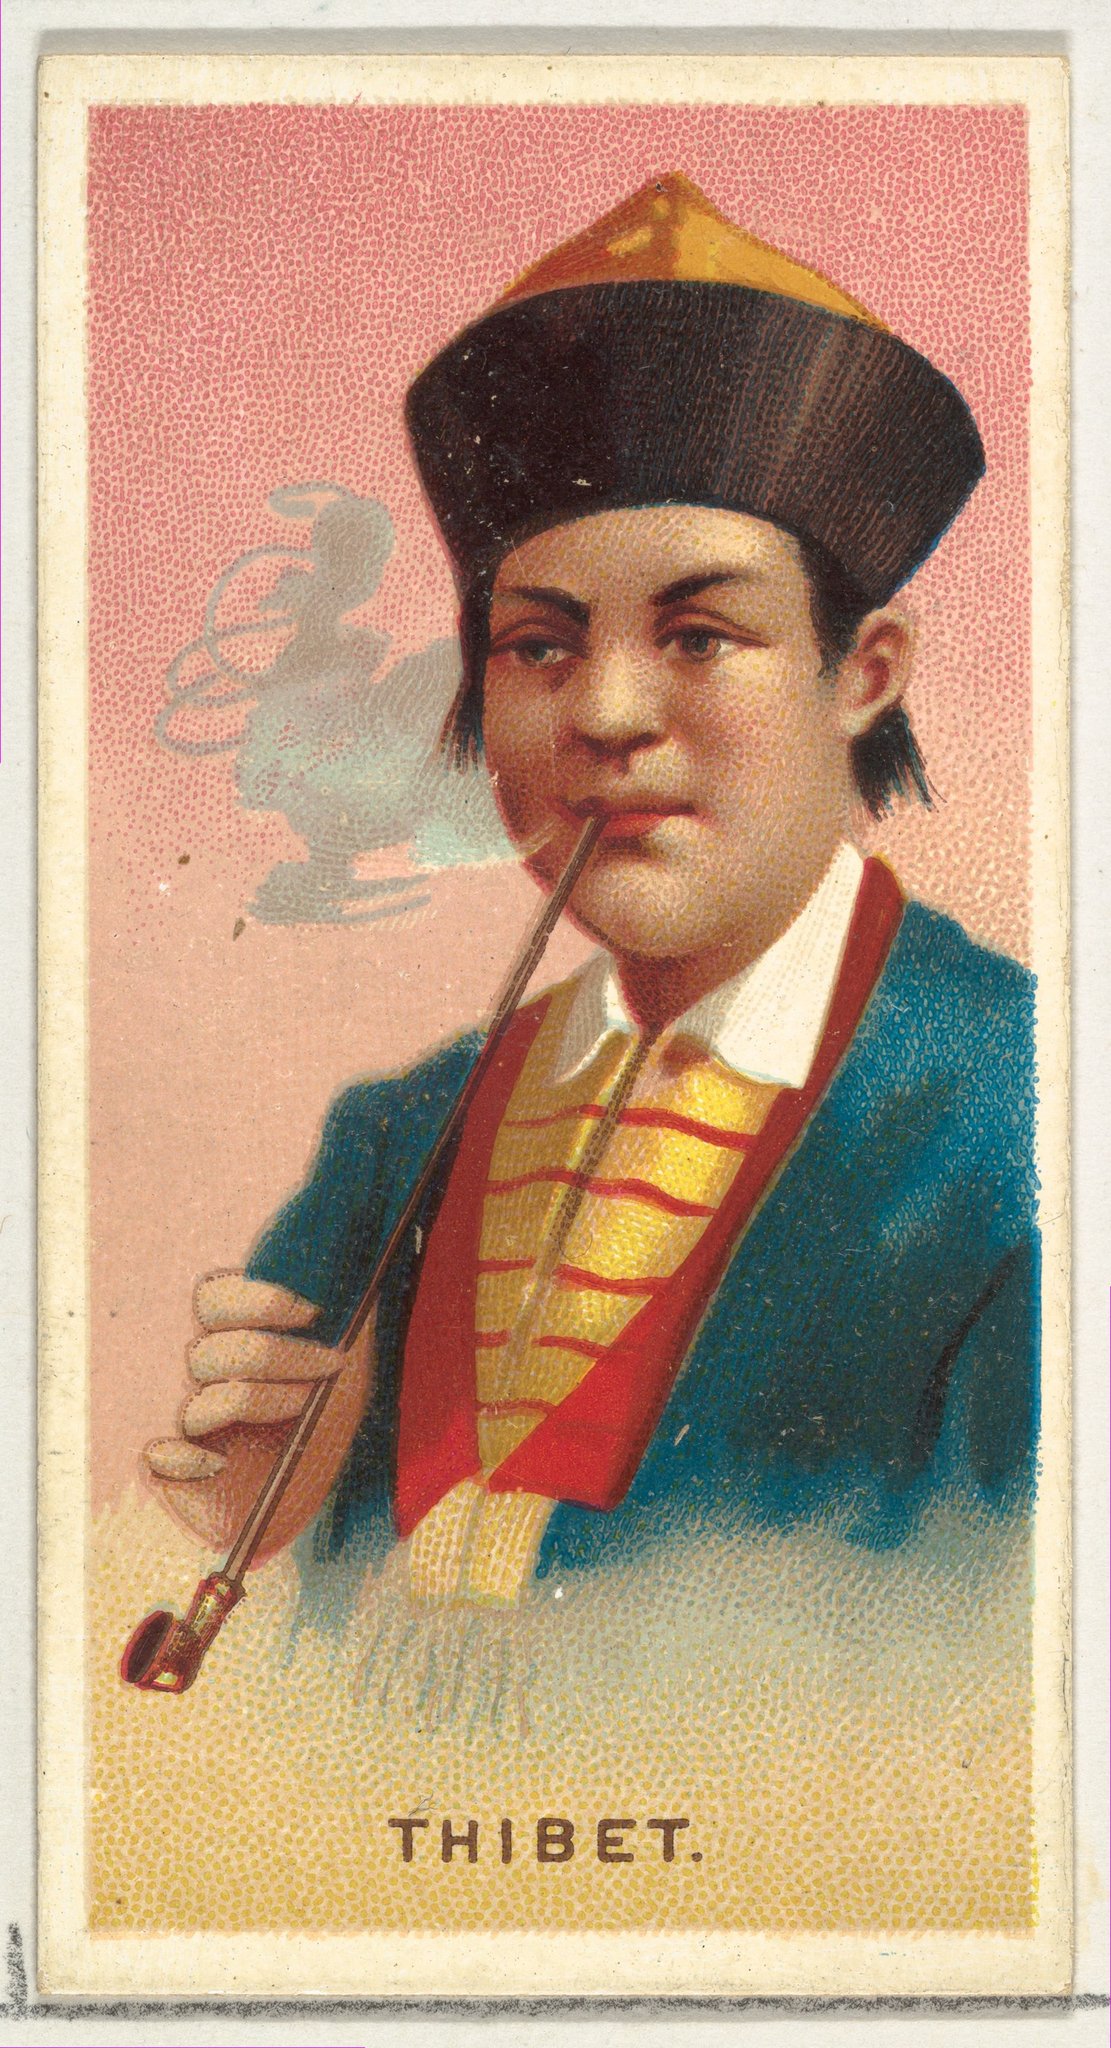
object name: print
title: Tibet, from World's Smokers series (N33) for Allen & Ginter Cigarettes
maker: allen & ginter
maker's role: publisher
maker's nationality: american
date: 1888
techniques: color lithograph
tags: men,smoking